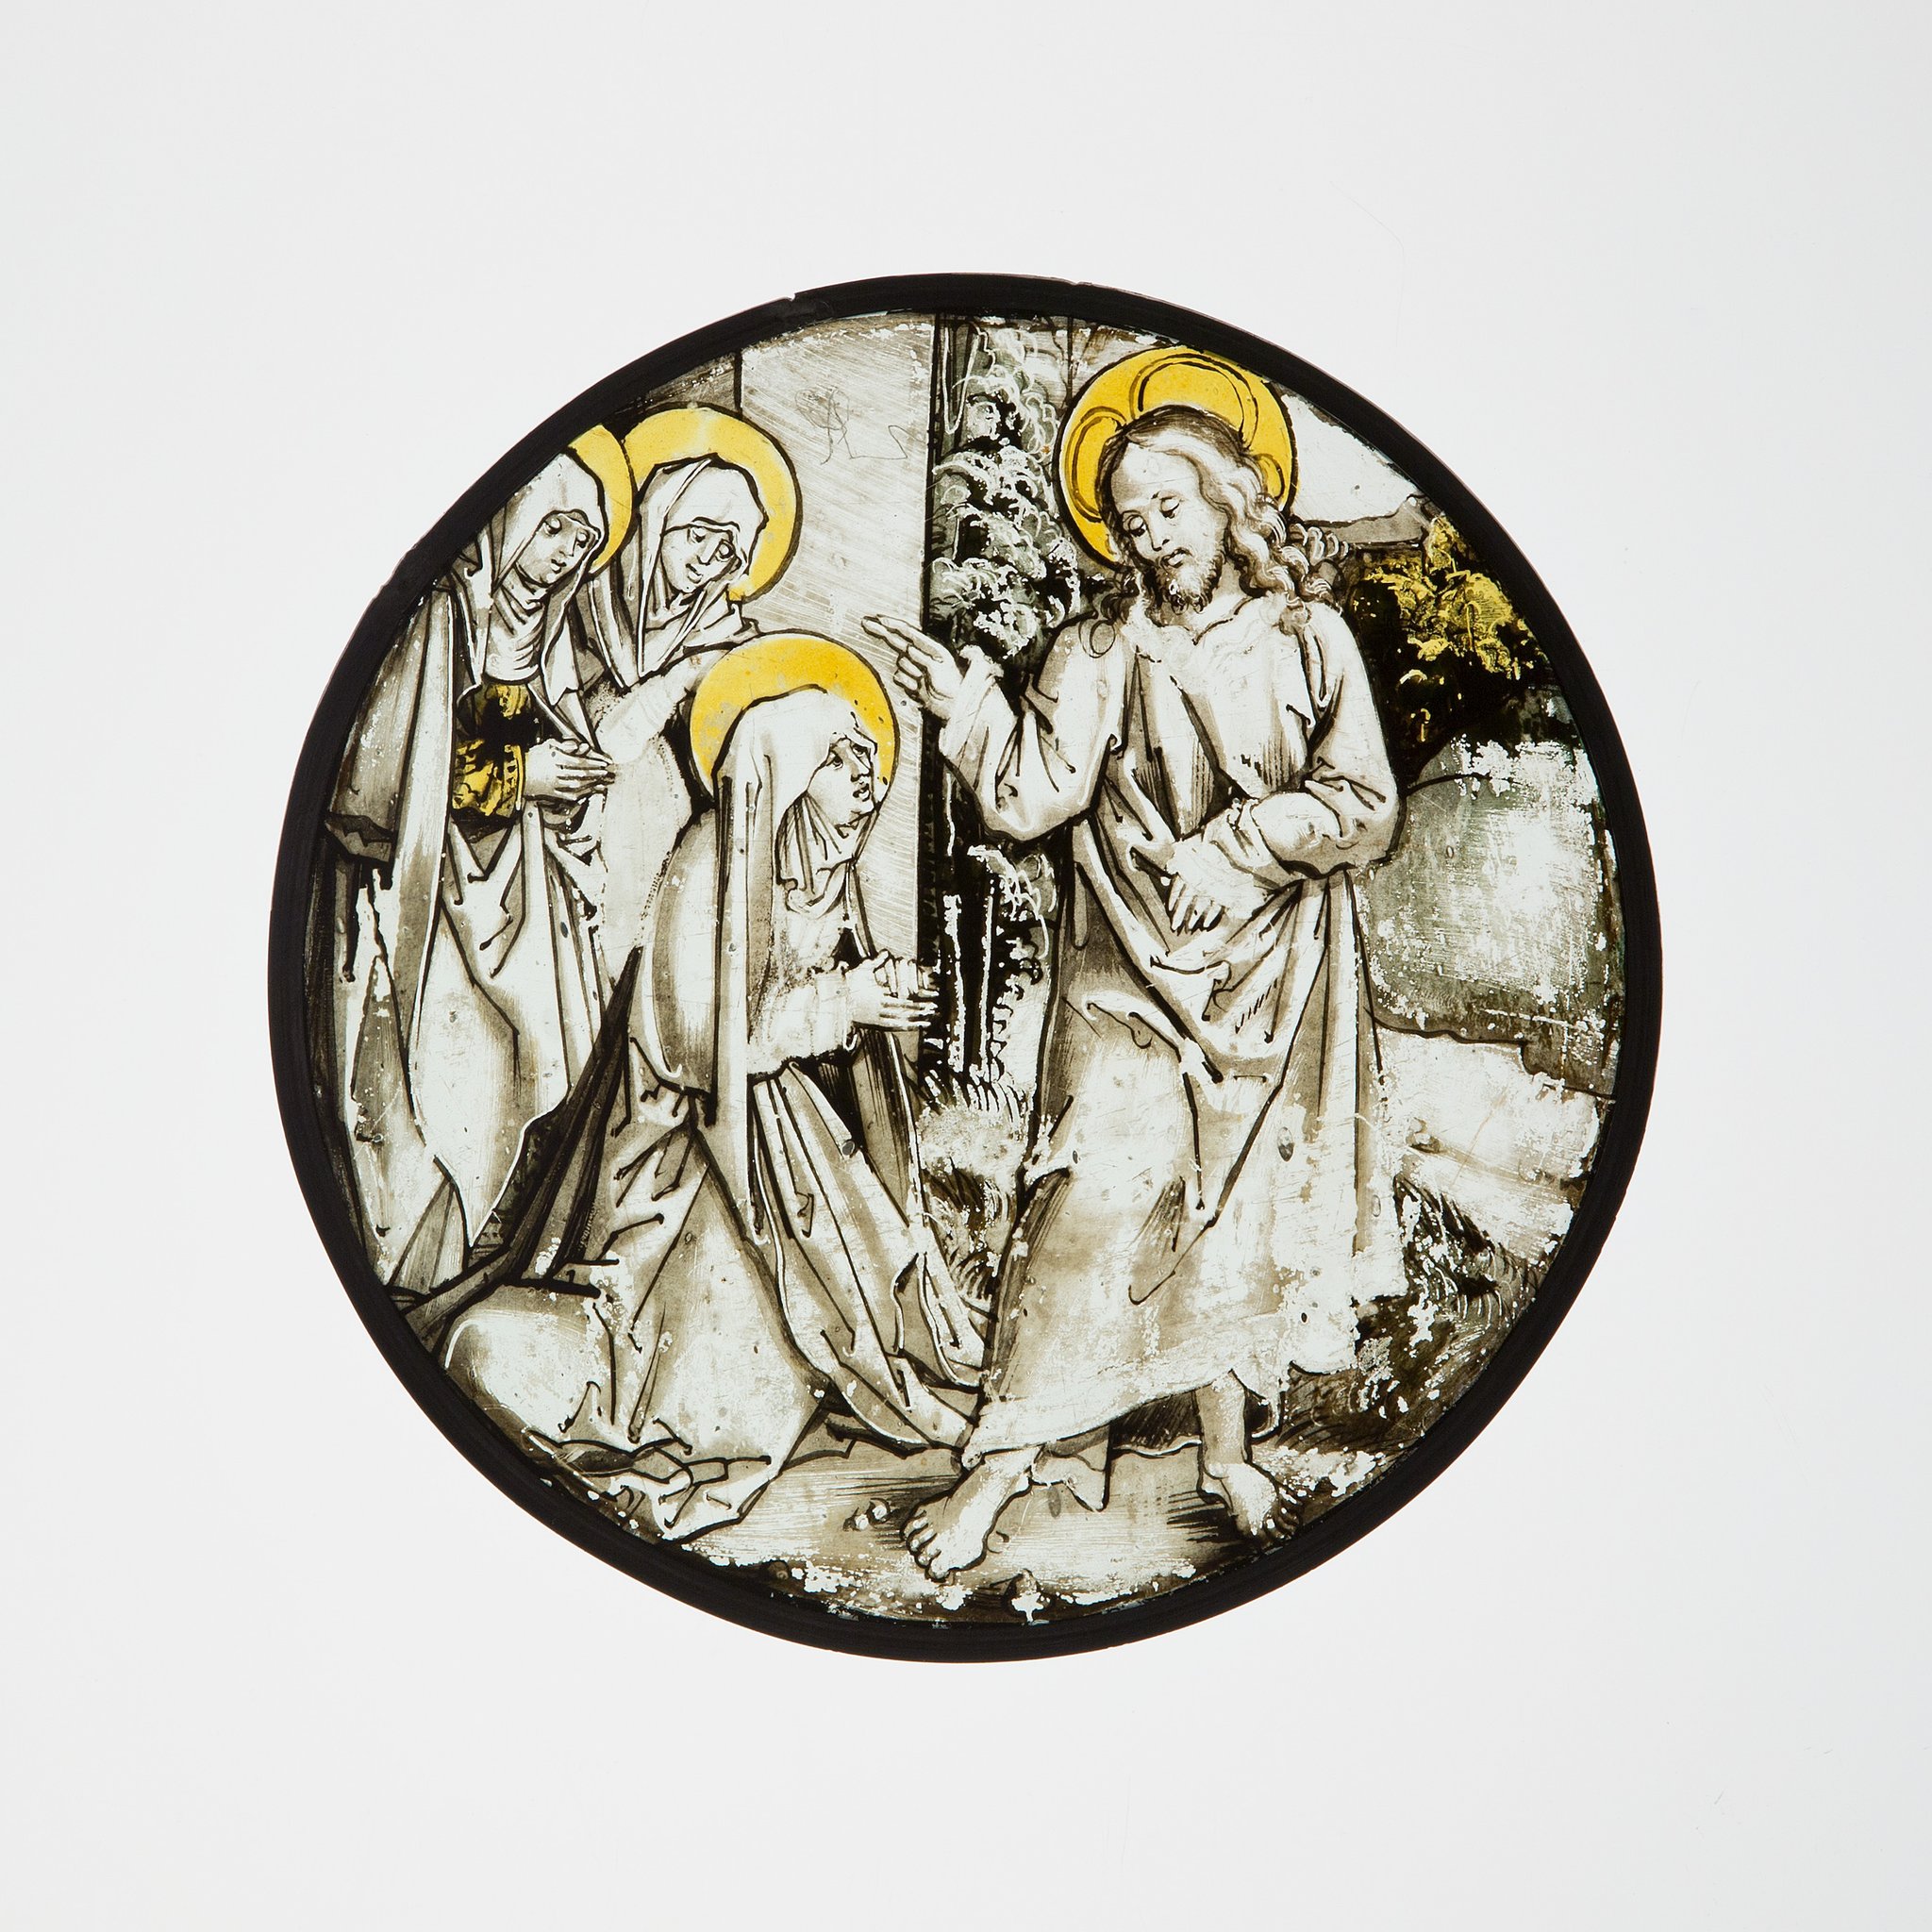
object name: roundel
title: Roundel with Christ Taking Leave of His Mother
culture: german, south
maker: hans schäufelein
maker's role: artist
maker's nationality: german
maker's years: 1480-1540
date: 1507-1515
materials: glass, paint, pigment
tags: women,christ,virgin mary